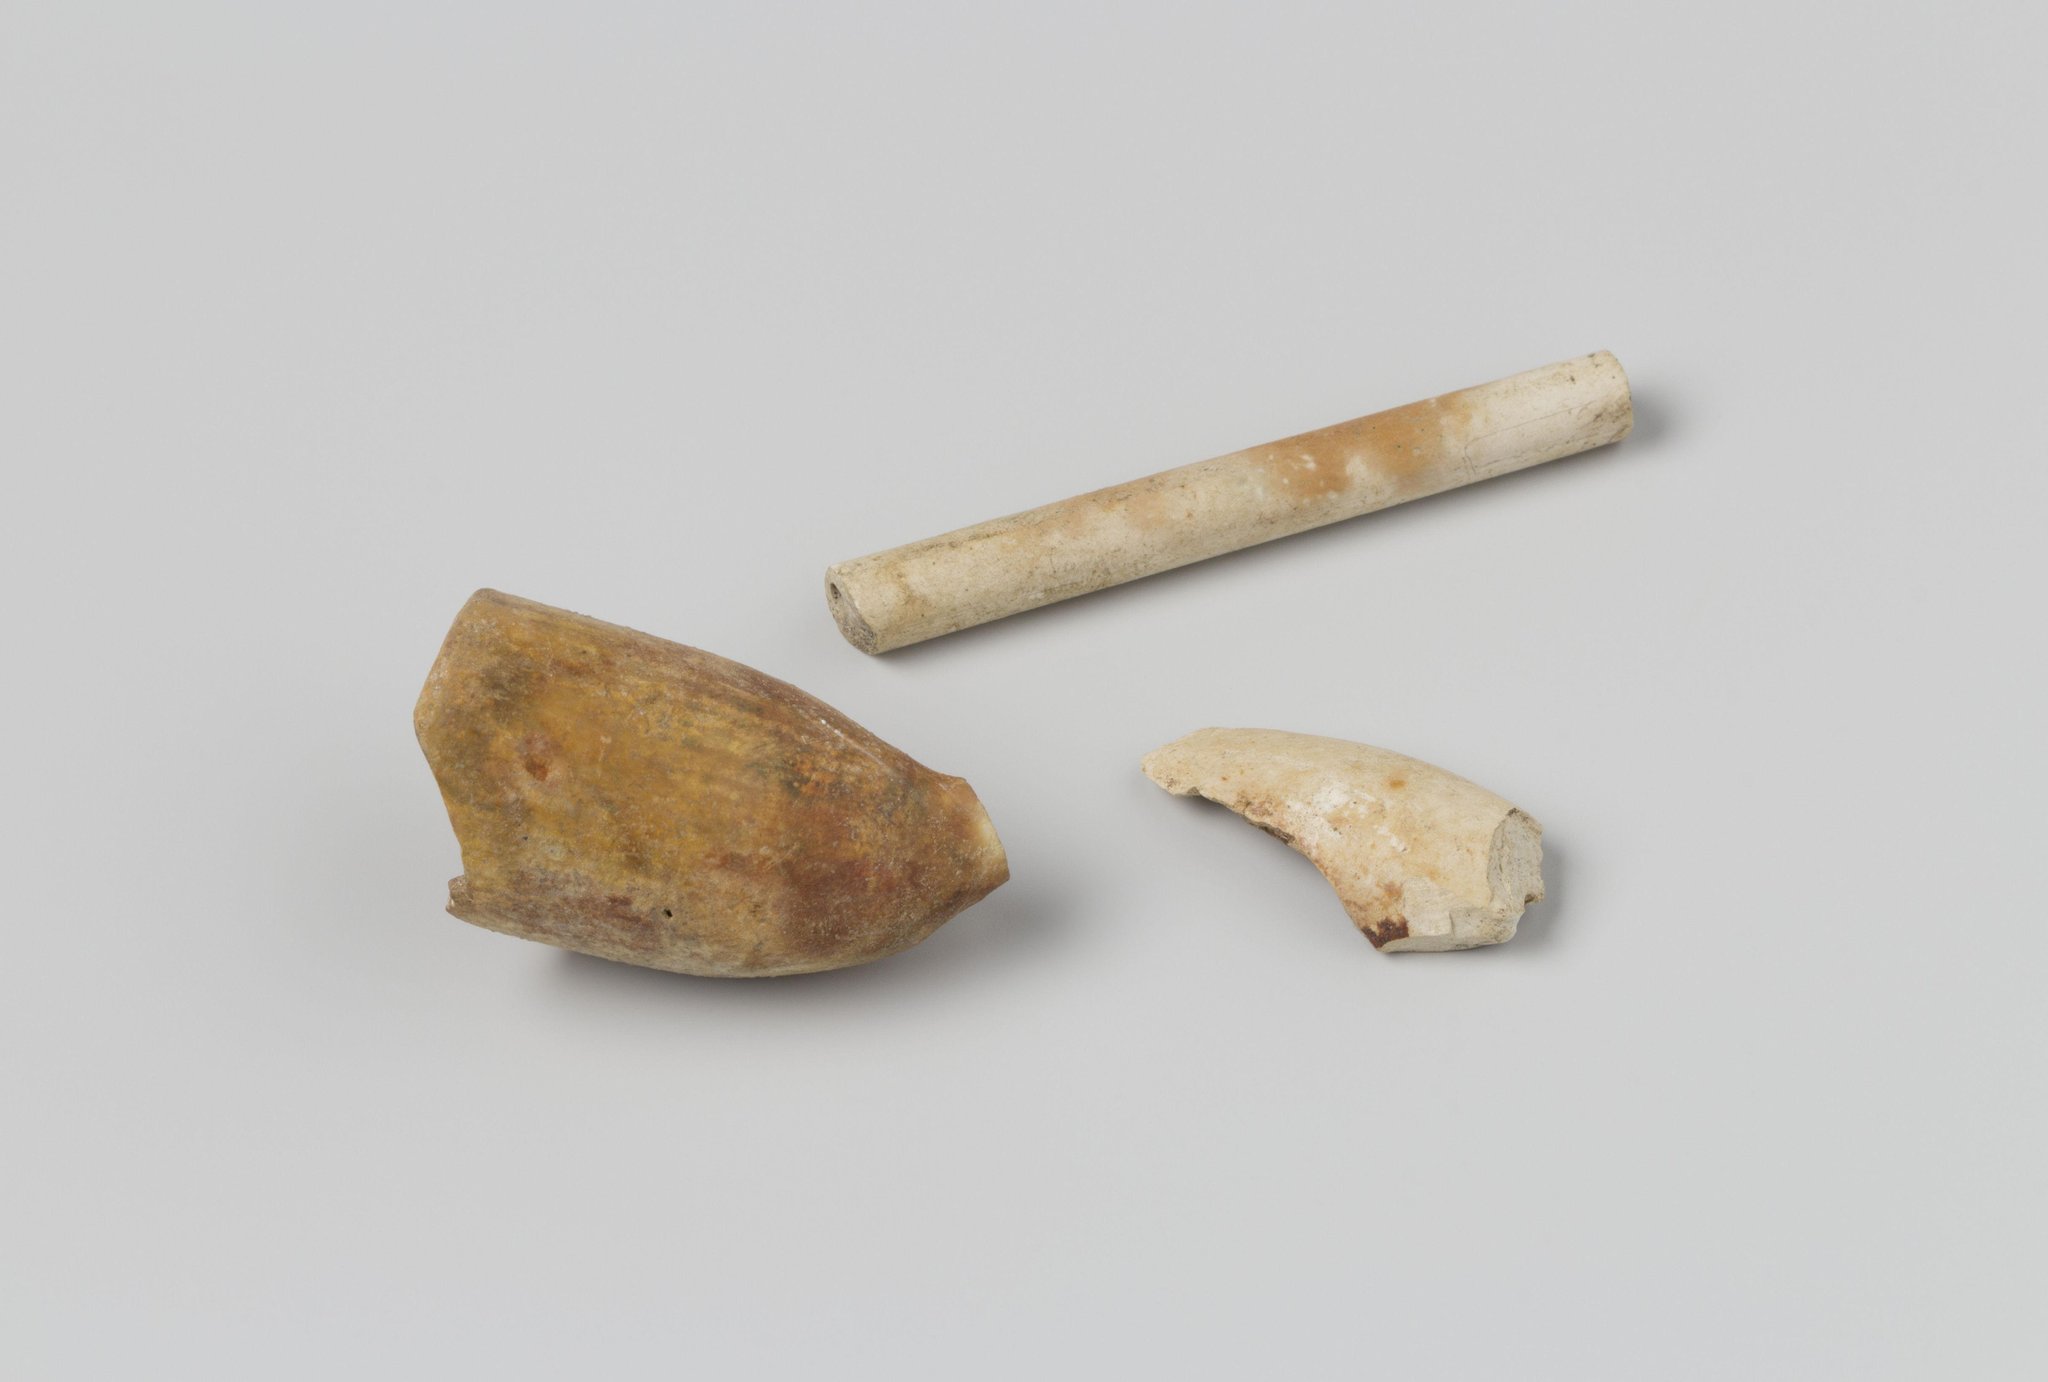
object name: pipe stem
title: Fragment pijpensteel en fragmenten pijpenkoppen uit het wrak van de Oost-Indiëvaarder Hollandia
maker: Anonymous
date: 1700-1743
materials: clay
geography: netherlands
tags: verenigde oostindische compagnie, hollandia (schip), annet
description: Pipe, bowl without heel: stamped decoration; fragm, imprint illegible.